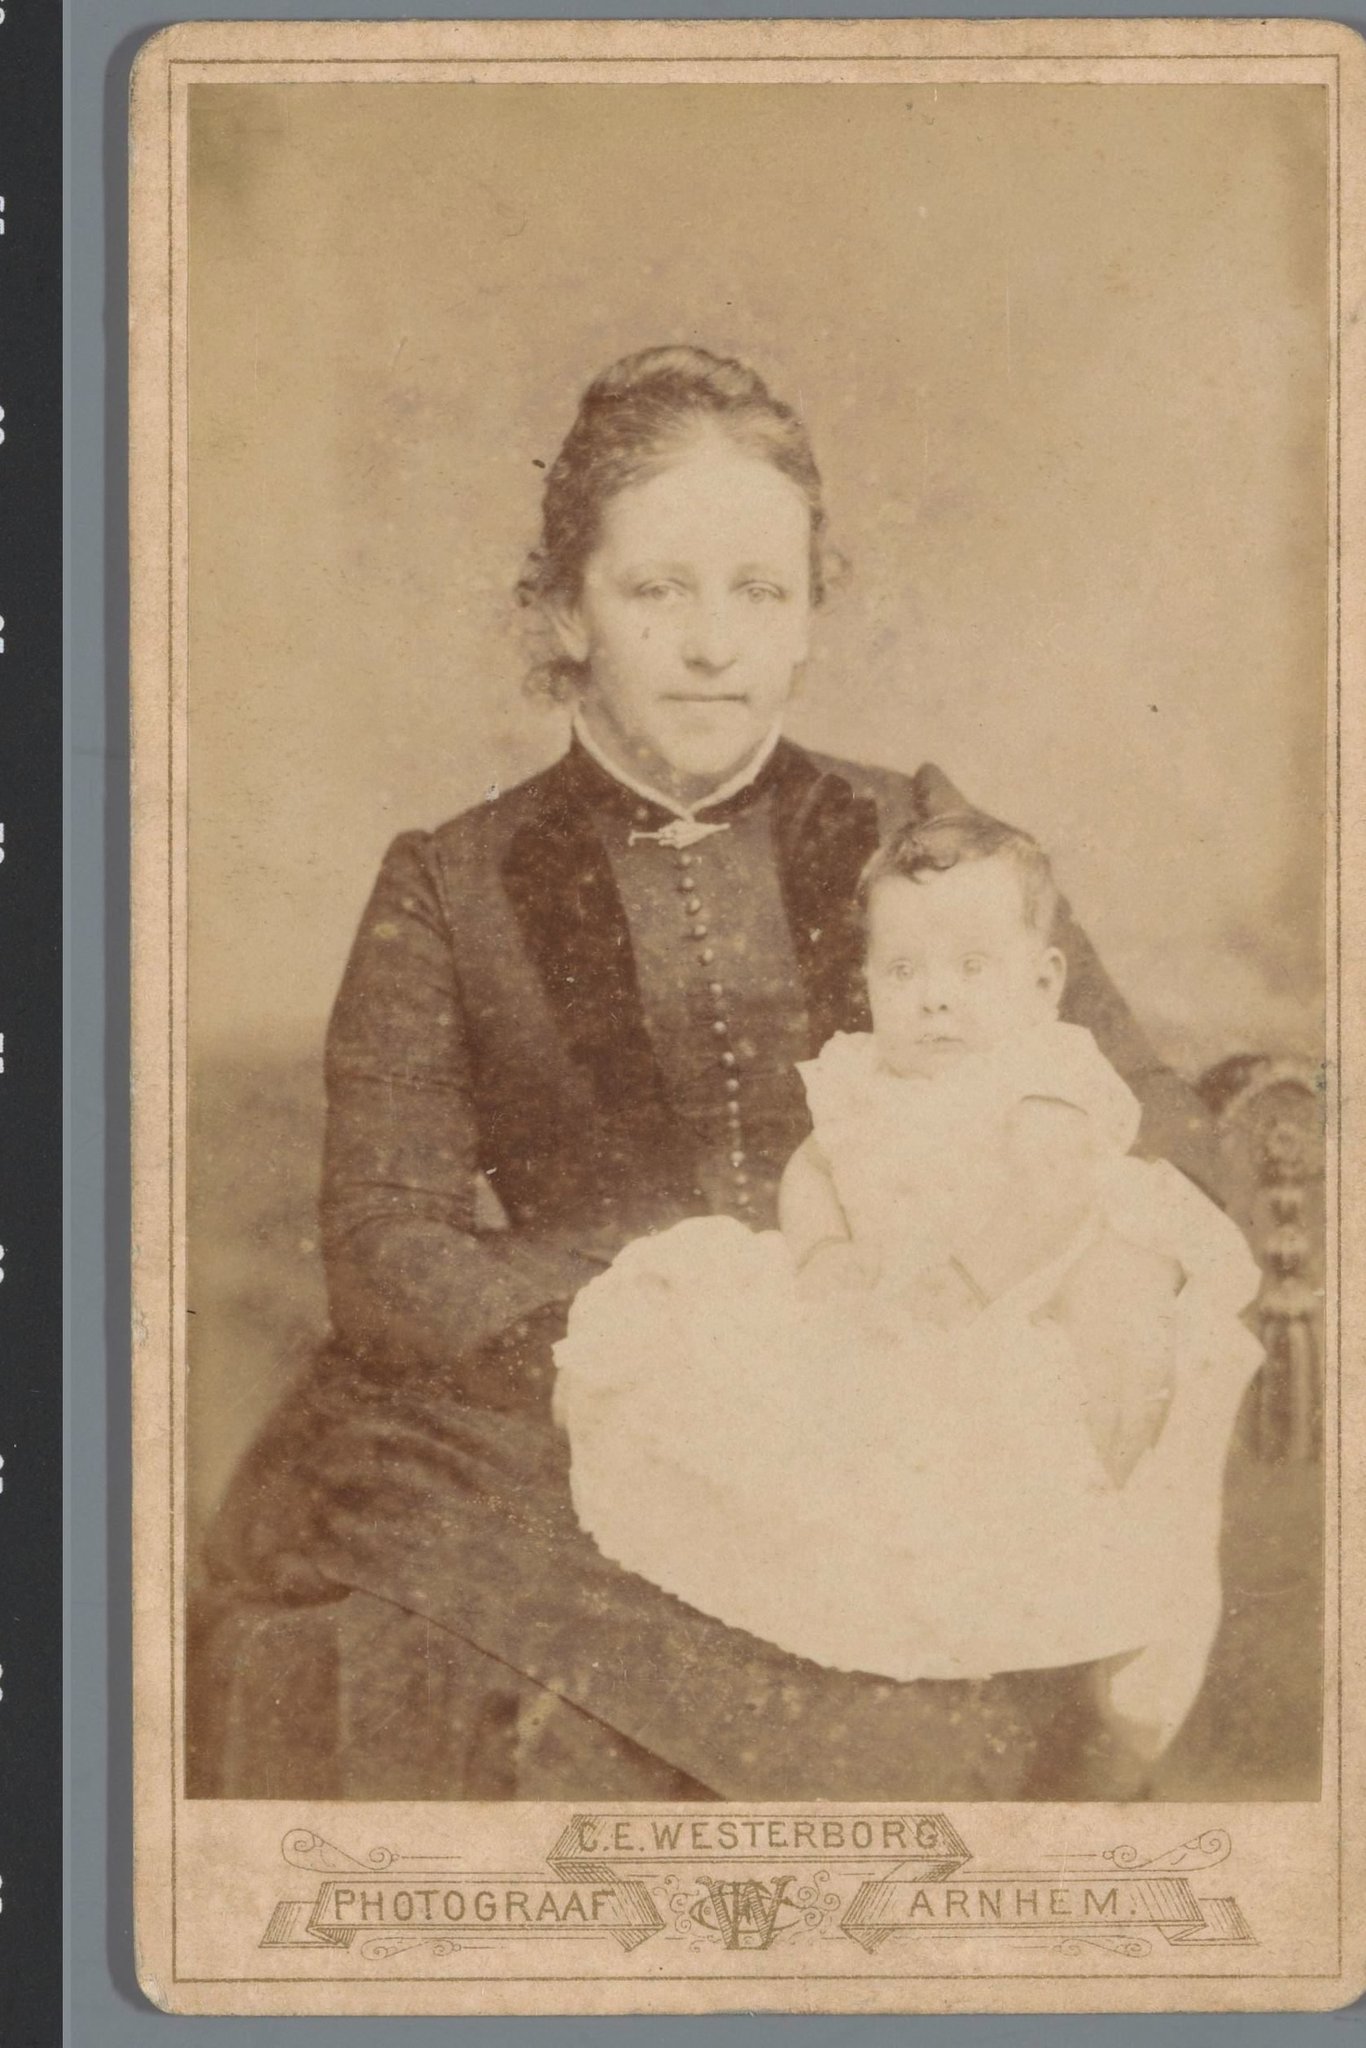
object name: photograph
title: Portret van Maria Catherina Heldring met een kind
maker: carel eduard westerborg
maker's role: fotograaf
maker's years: 1842-1916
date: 1886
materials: cardboard, paper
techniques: albumen print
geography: arnhem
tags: adolescent, young woman, maiden, child, historical persons, mother and baby or young child, arnhem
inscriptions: monogram: ‘CEW’, inscription: ‘C.E. Westerborg/ Photograaf/ Arnhem.’, monogram: ‘CEW’, inscription: ‘C.E. Westerborg/ Photographisch Atelier/ Arnhem/ Vossenstraat B. 66./ Voor nabestelling worden alle negatieven bewaard./ Muster-Schutz L.G.K. & E.’, inscription: ‘Maria Catherina/ Heldring/ 4 Oct. 1886’